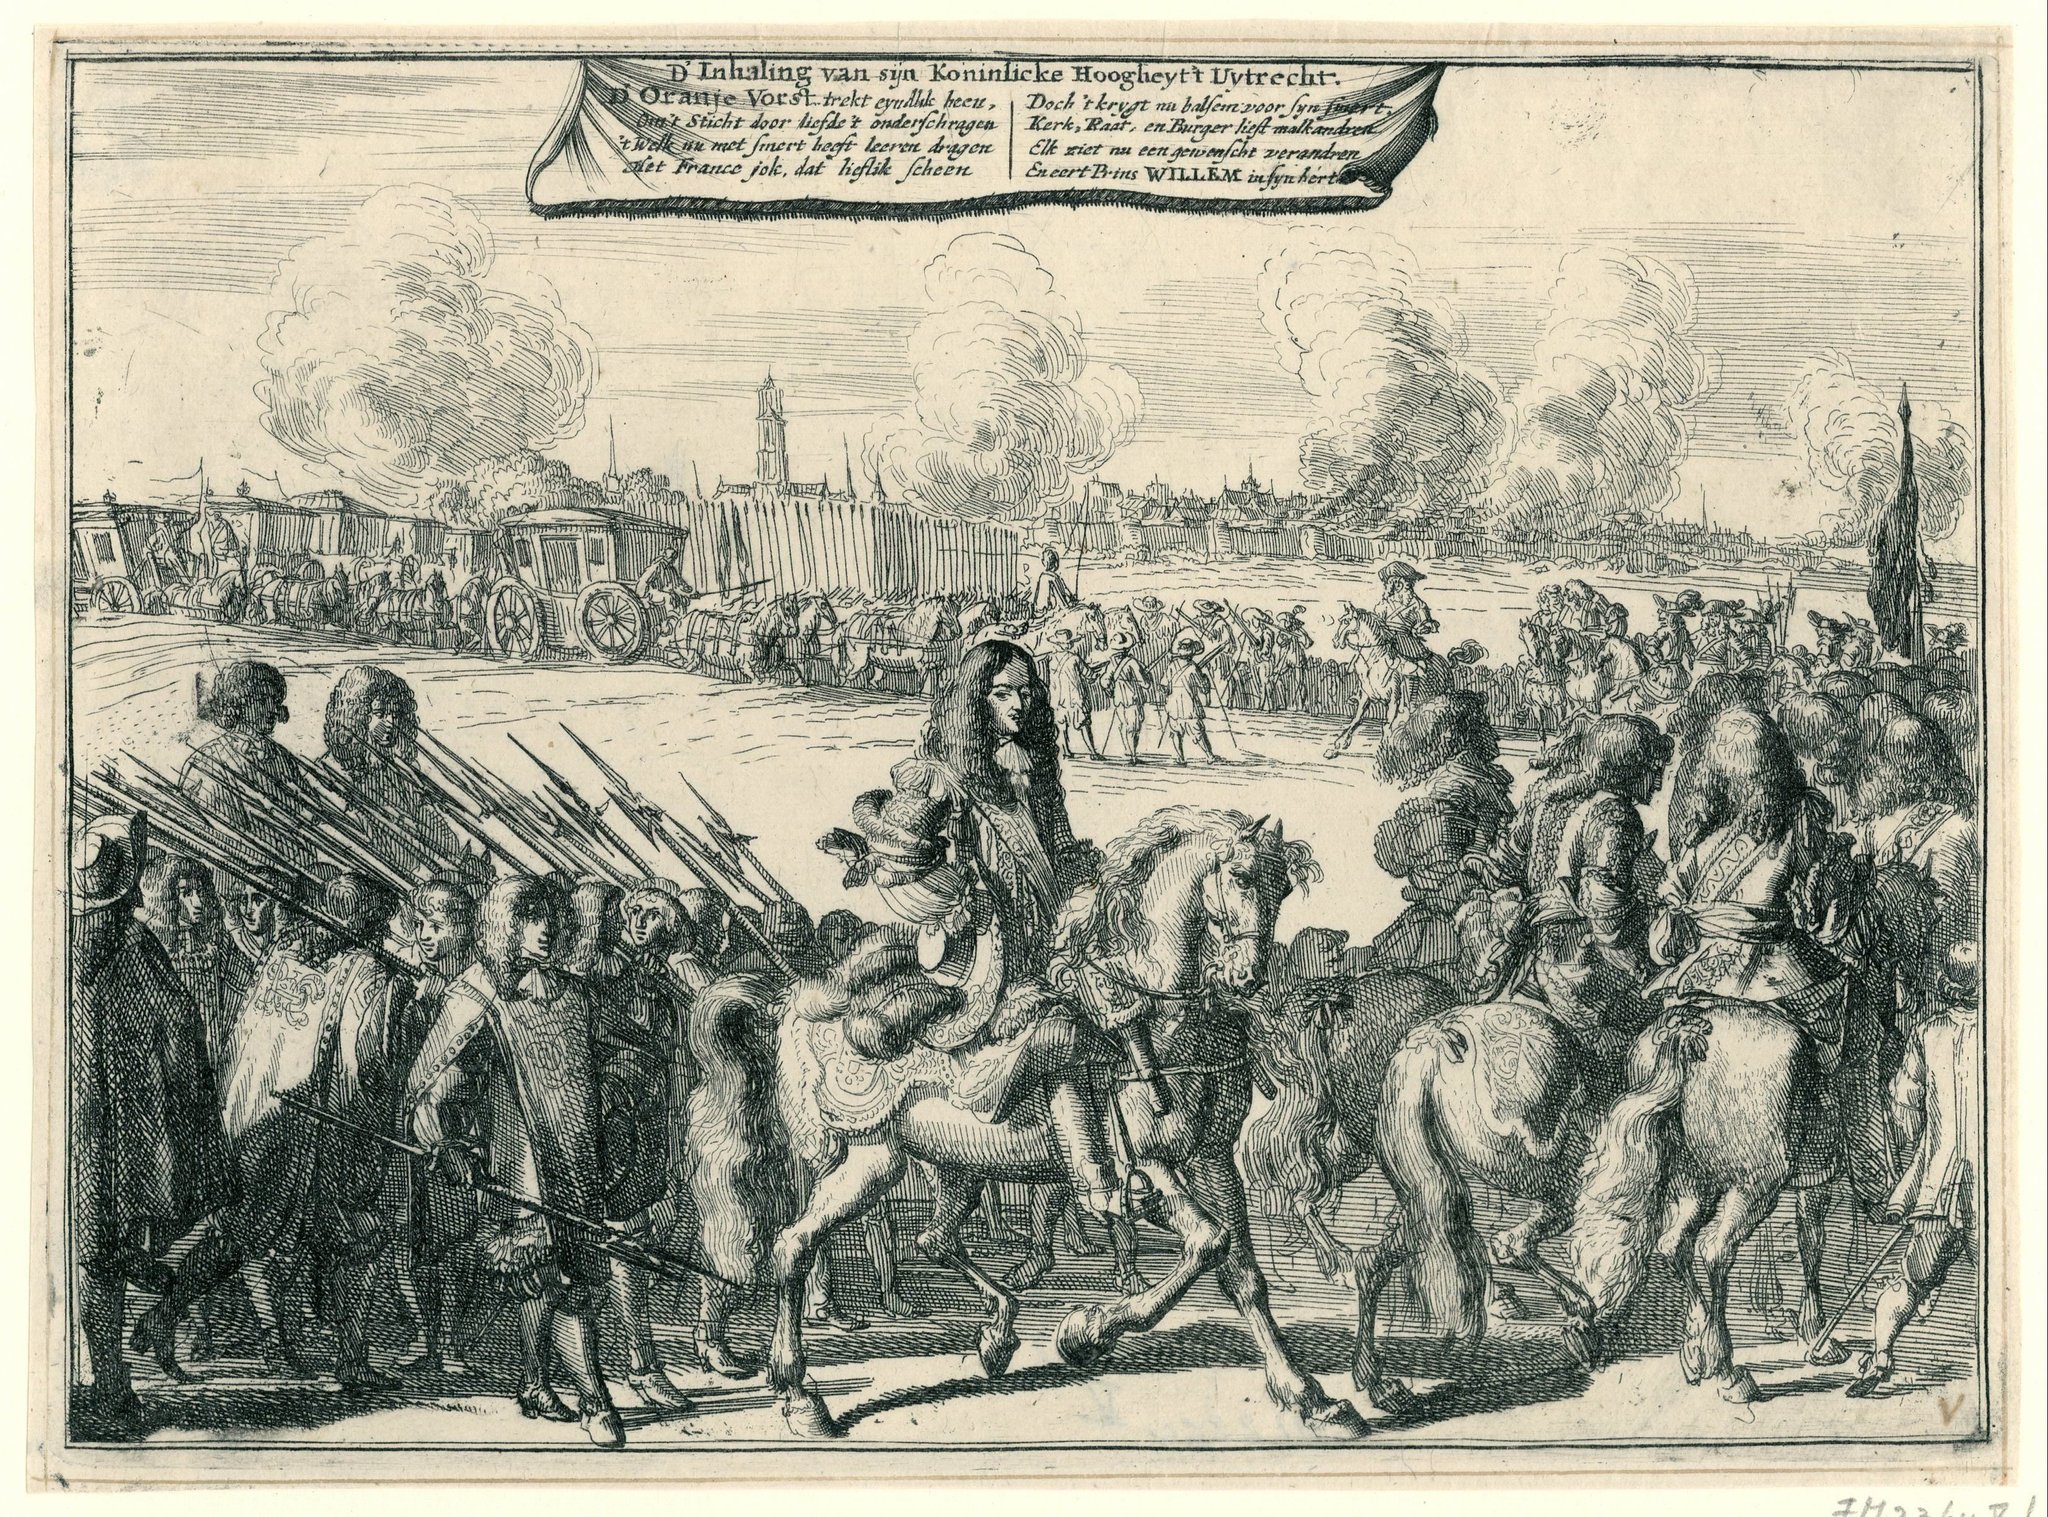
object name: print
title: Reeks van vijf prenten over de gebeurtenissen voorgevallen in Utrecht over de periode 1672-74 (heruitgave door Schoonebeek)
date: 1674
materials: paper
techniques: etching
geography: amsterdam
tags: the hague, william iii (prince of orange and king of england, scotland, and ireland), triumphal entry and public reception, pageant, 'entrée solennelle', 'joyeuse entrée', utrecht, rampjaar (disaster year)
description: De aankomst van prins Willem III te Utrecht in april 1674. De prins centraal te paard te midden van ruiters en voetsoldaten. Op de achtergrond de stad Utrecht. Bovenaan een doek met de titel en twee vierregelige verzen in het Nederlands. Vijfde (ongenummerde) prent in een reeks van vijf prenten over de gebeurtenissen voorgevallen in Utrecht over de periode 1672-74.